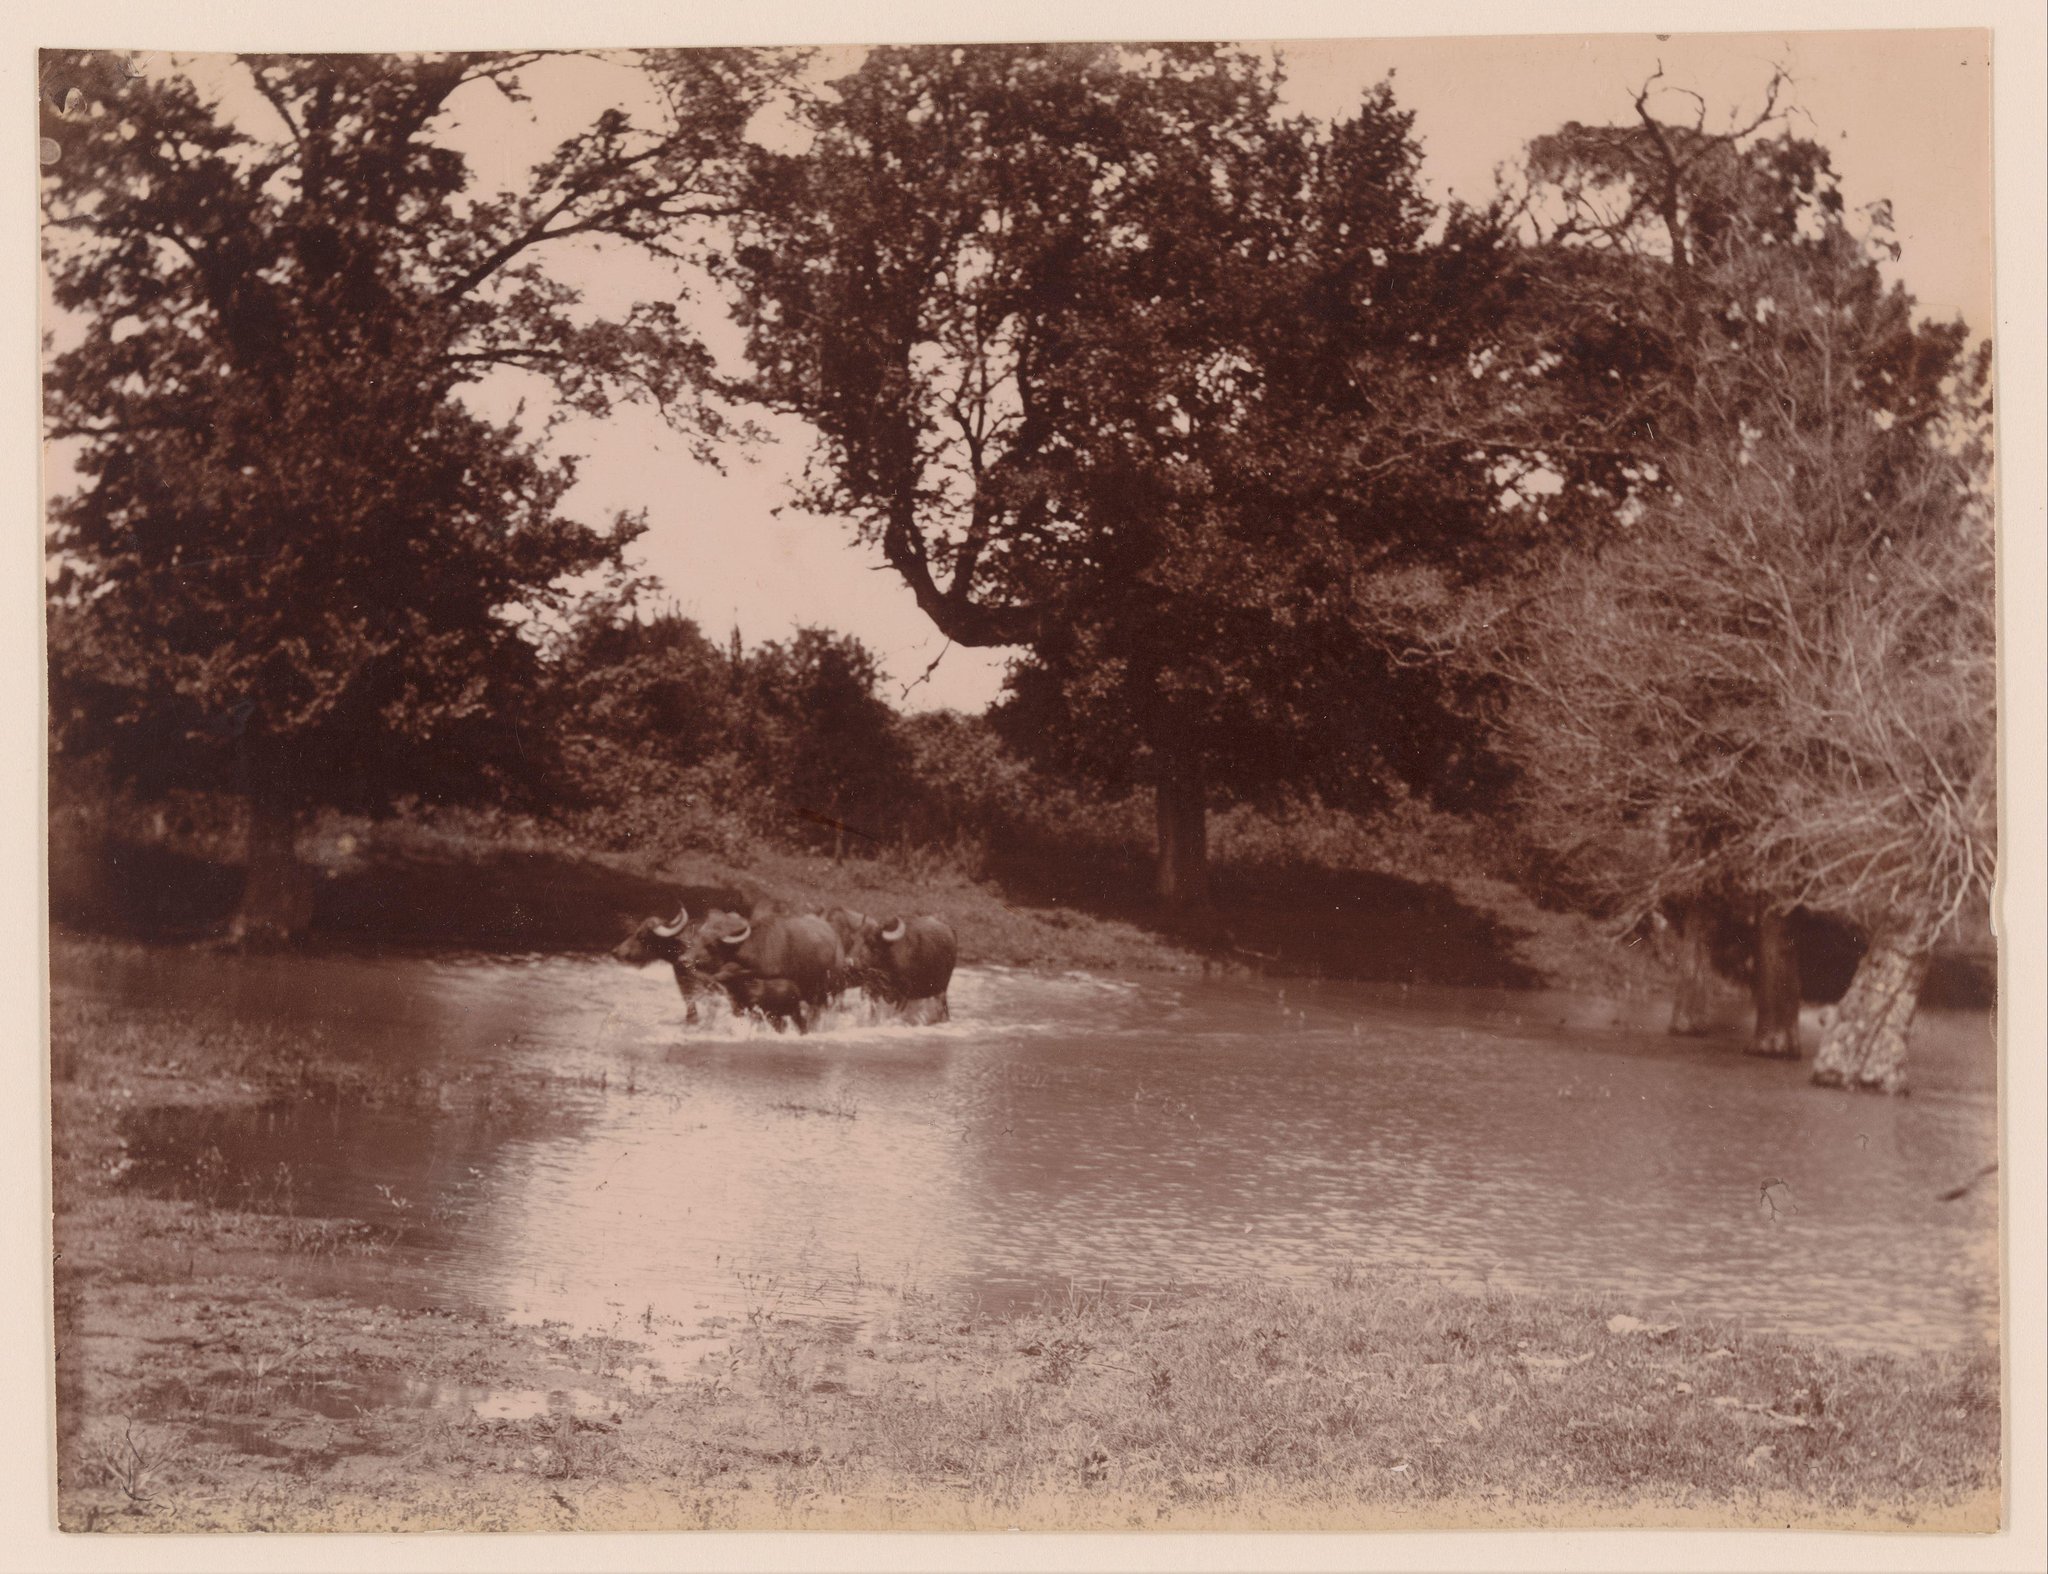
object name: photograph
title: Buffels in een rivier of plas, nabij Mairano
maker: Anonymous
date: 1890-1910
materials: paper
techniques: gelatin silver print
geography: mairano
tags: swamp, inland marsh, fens, hoofed animals: water buffalo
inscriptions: inscription: ‘Mairanese/ Buffel mit Kälbern/ 148’, collector's mark: ‘Vosmaer’